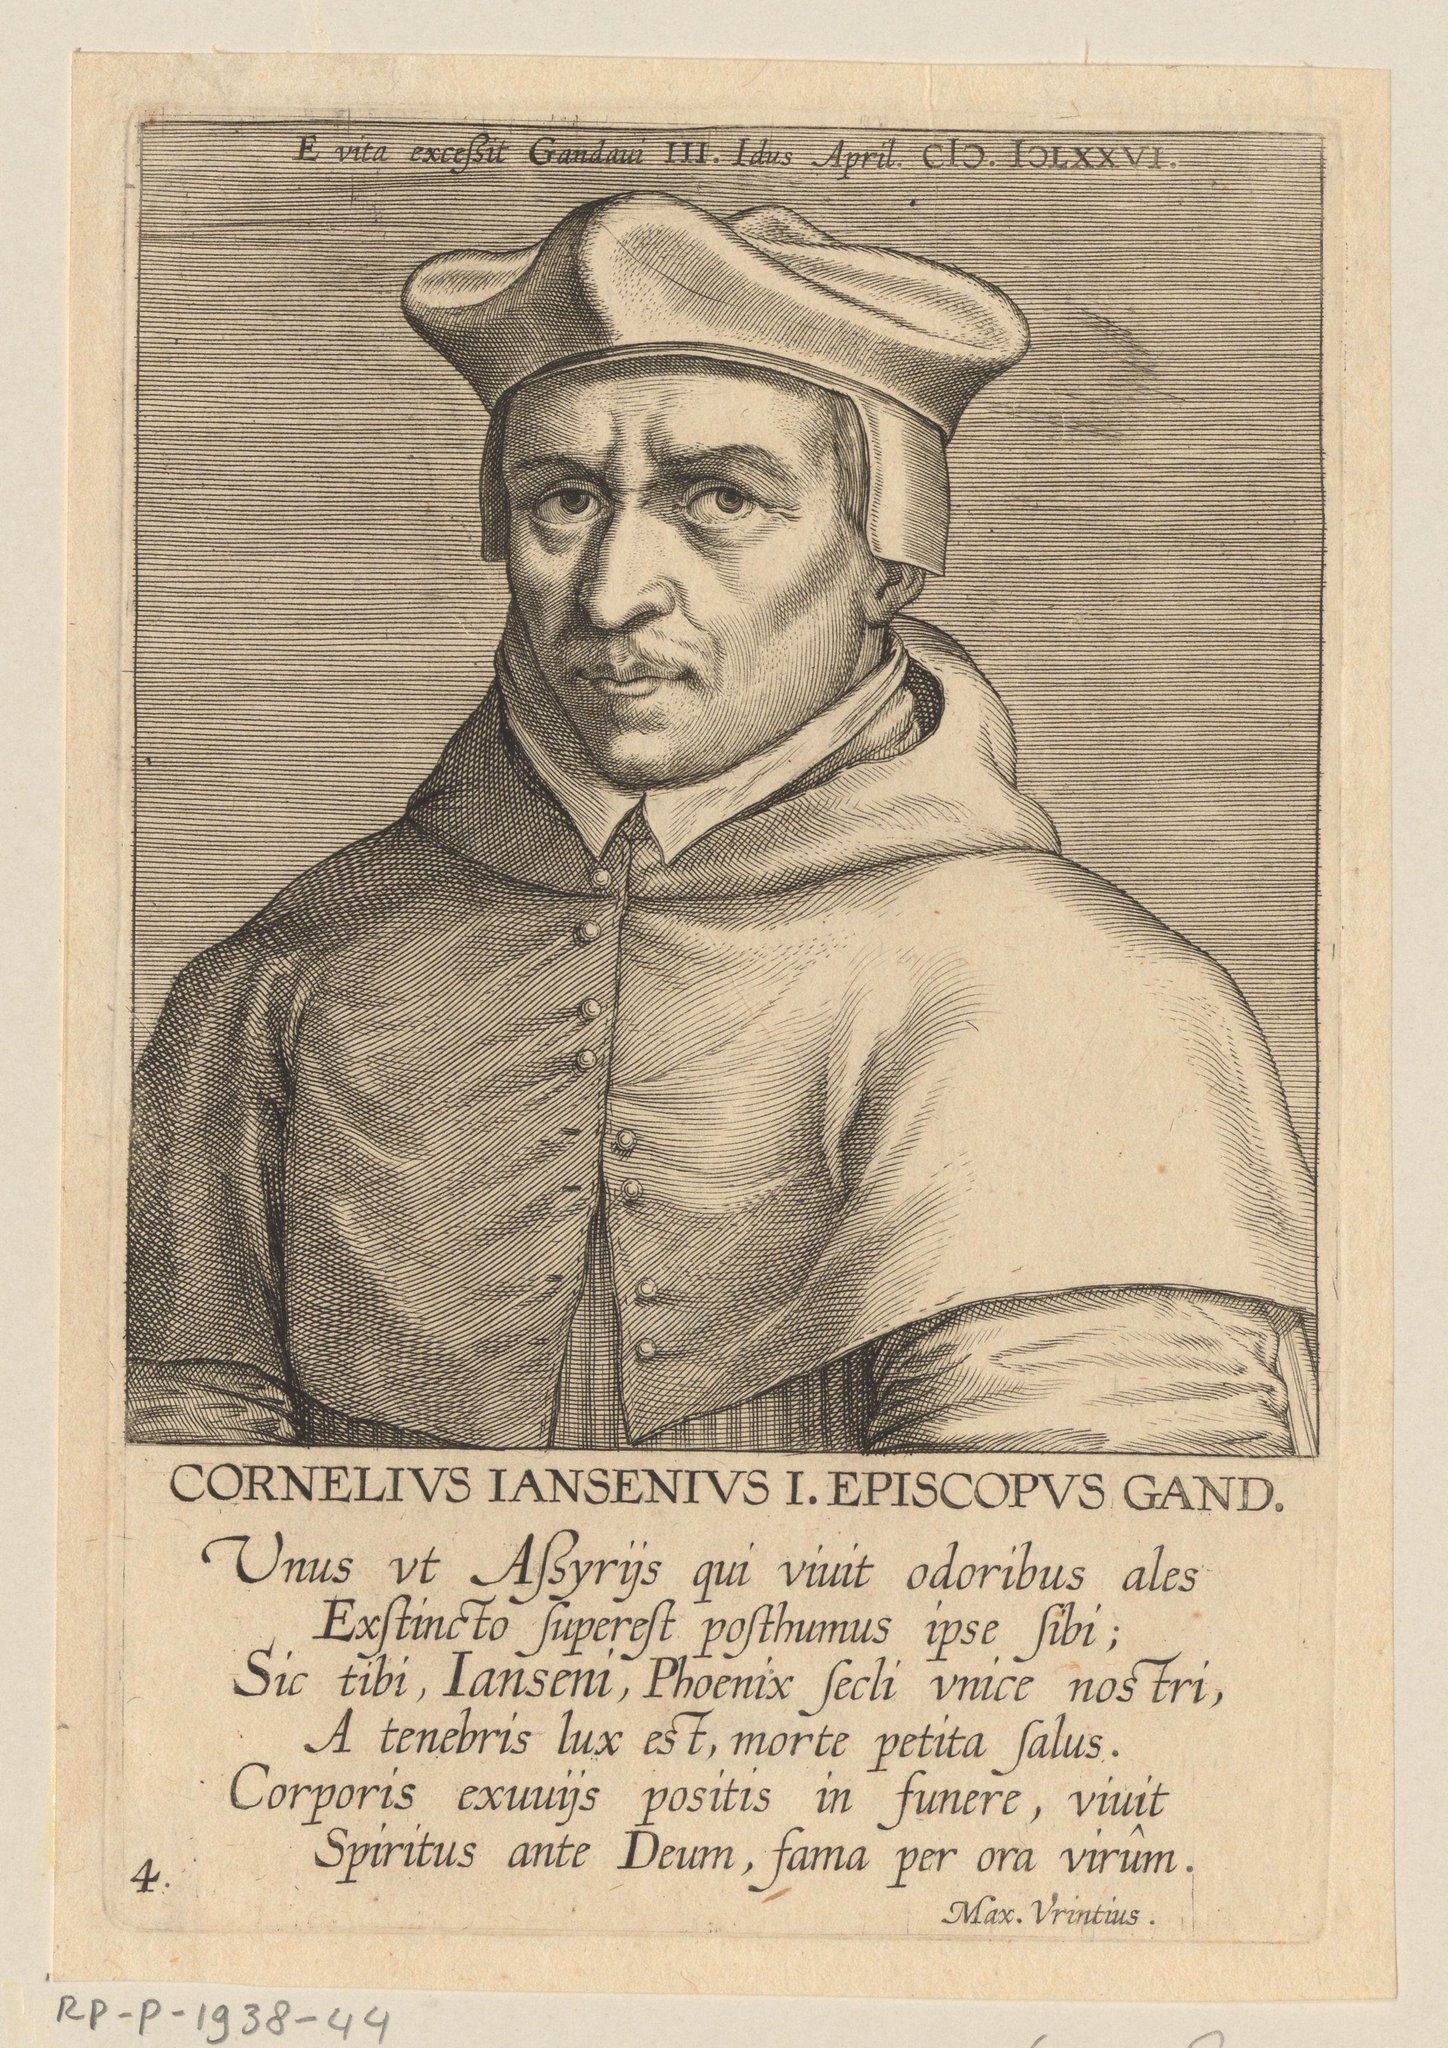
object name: print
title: Portretten van beroemde Nederlandse en Vlaamse geleerden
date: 1604-1608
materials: paper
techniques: engraving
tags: cornelius jansenius, archbishop, bishop, etc. (roman catholic), historical persons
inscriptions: collector's mark: Lugt 2228